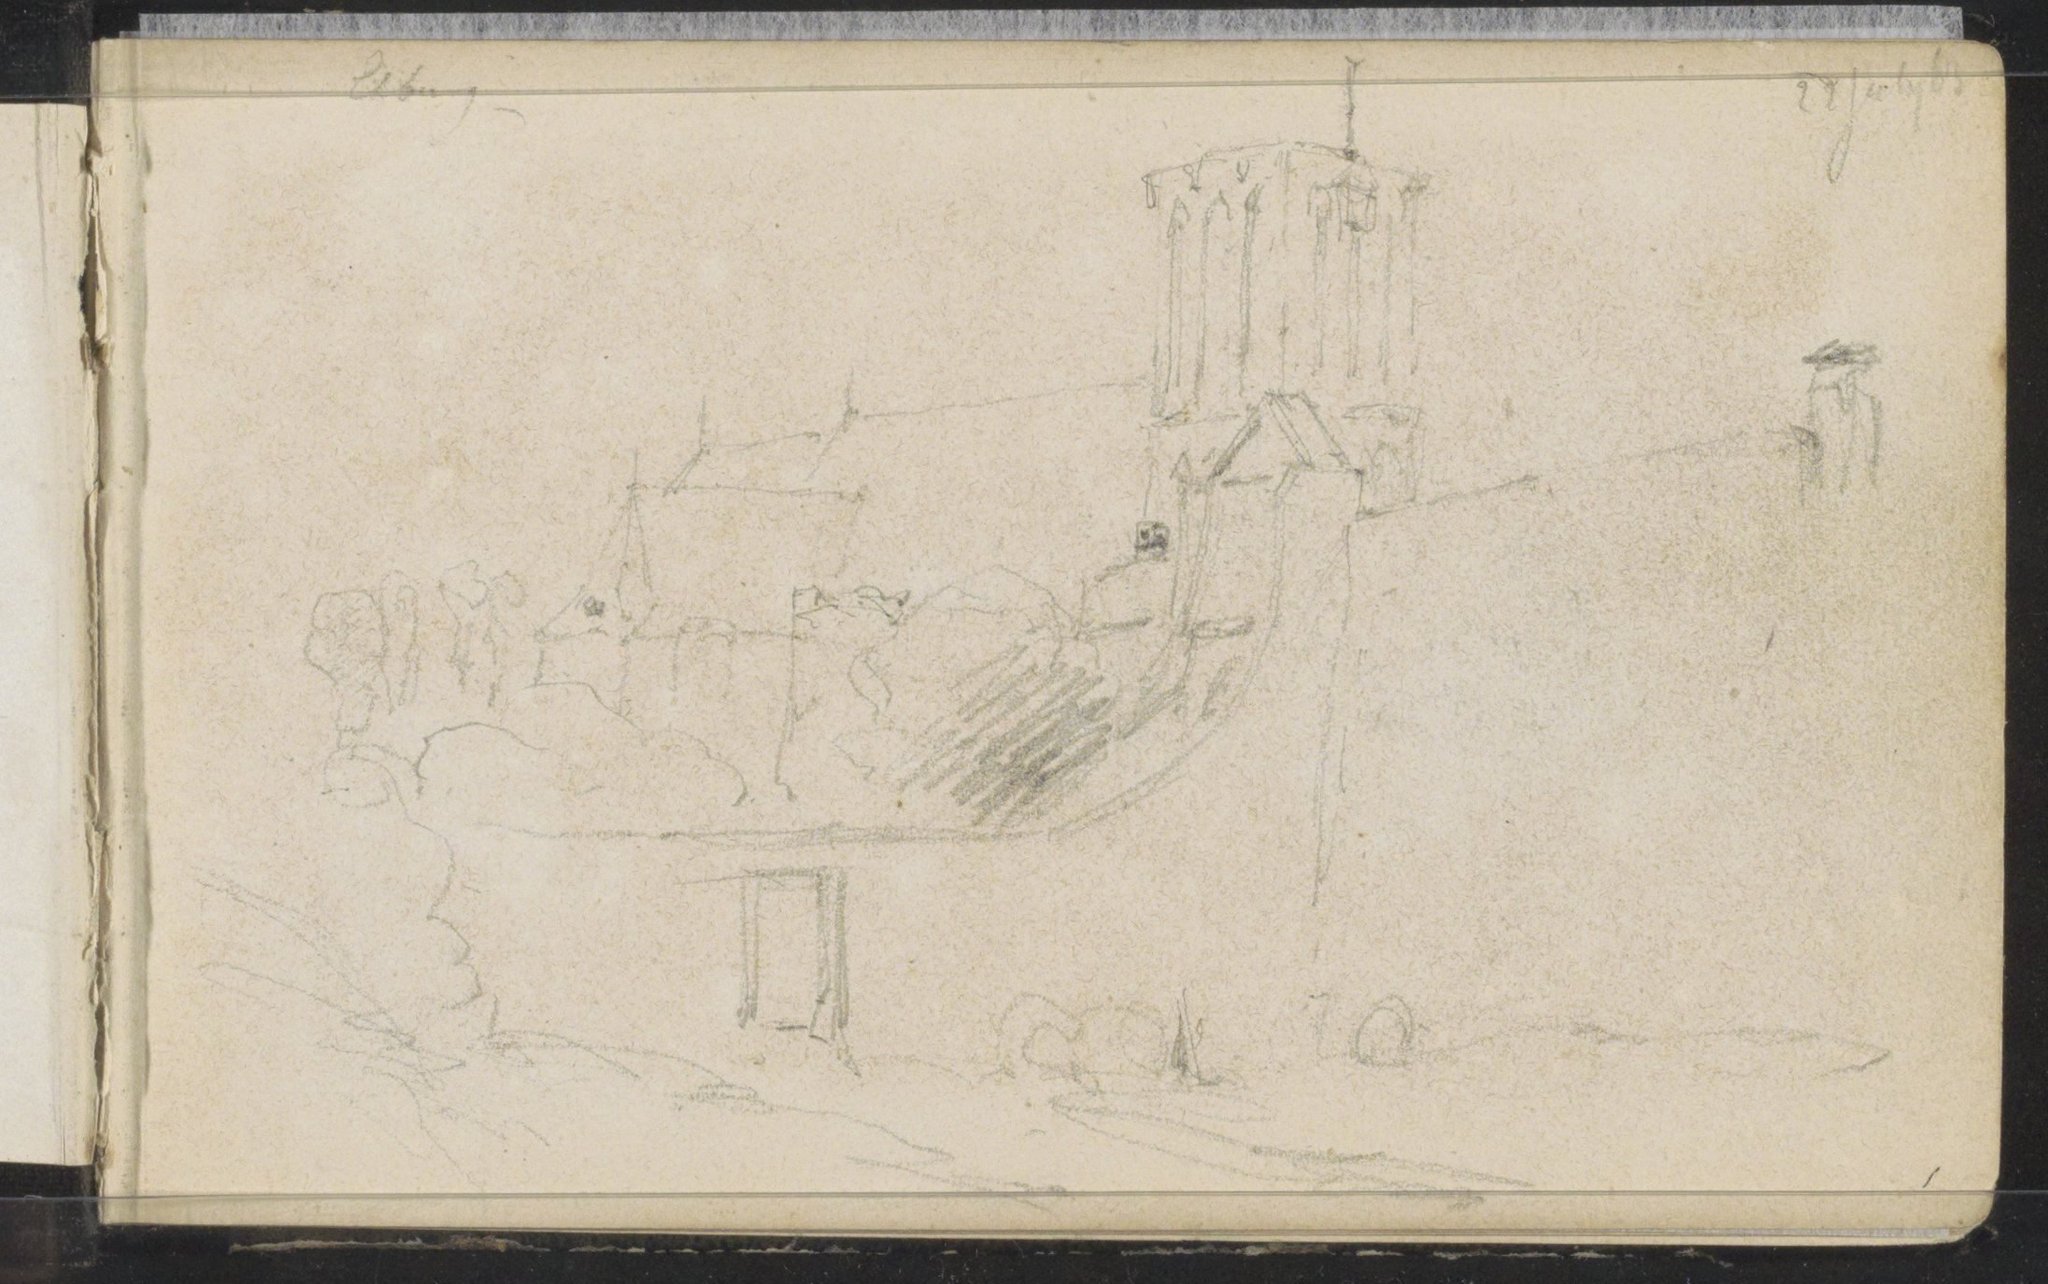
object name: sketchbook leaf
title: Gezicht op Elburg met de Sint-Nicolaaskerk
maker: cornelis springer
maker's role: draughtsman, painter, print maker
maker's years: 1817-1891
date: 1863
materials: paper, pencil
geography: elburg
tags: city-view, and landscape with man-made constructions, church (exterior)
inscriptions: annotation: ‘Elburg’, date: ‘22 july 63’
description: Gezicht op Elburg met de Sint-Nicolaaskerk. Blad 1 uit een schetsboek met 55 bladen vervaardigd op de Veluwe en in Noord-Duitsland.